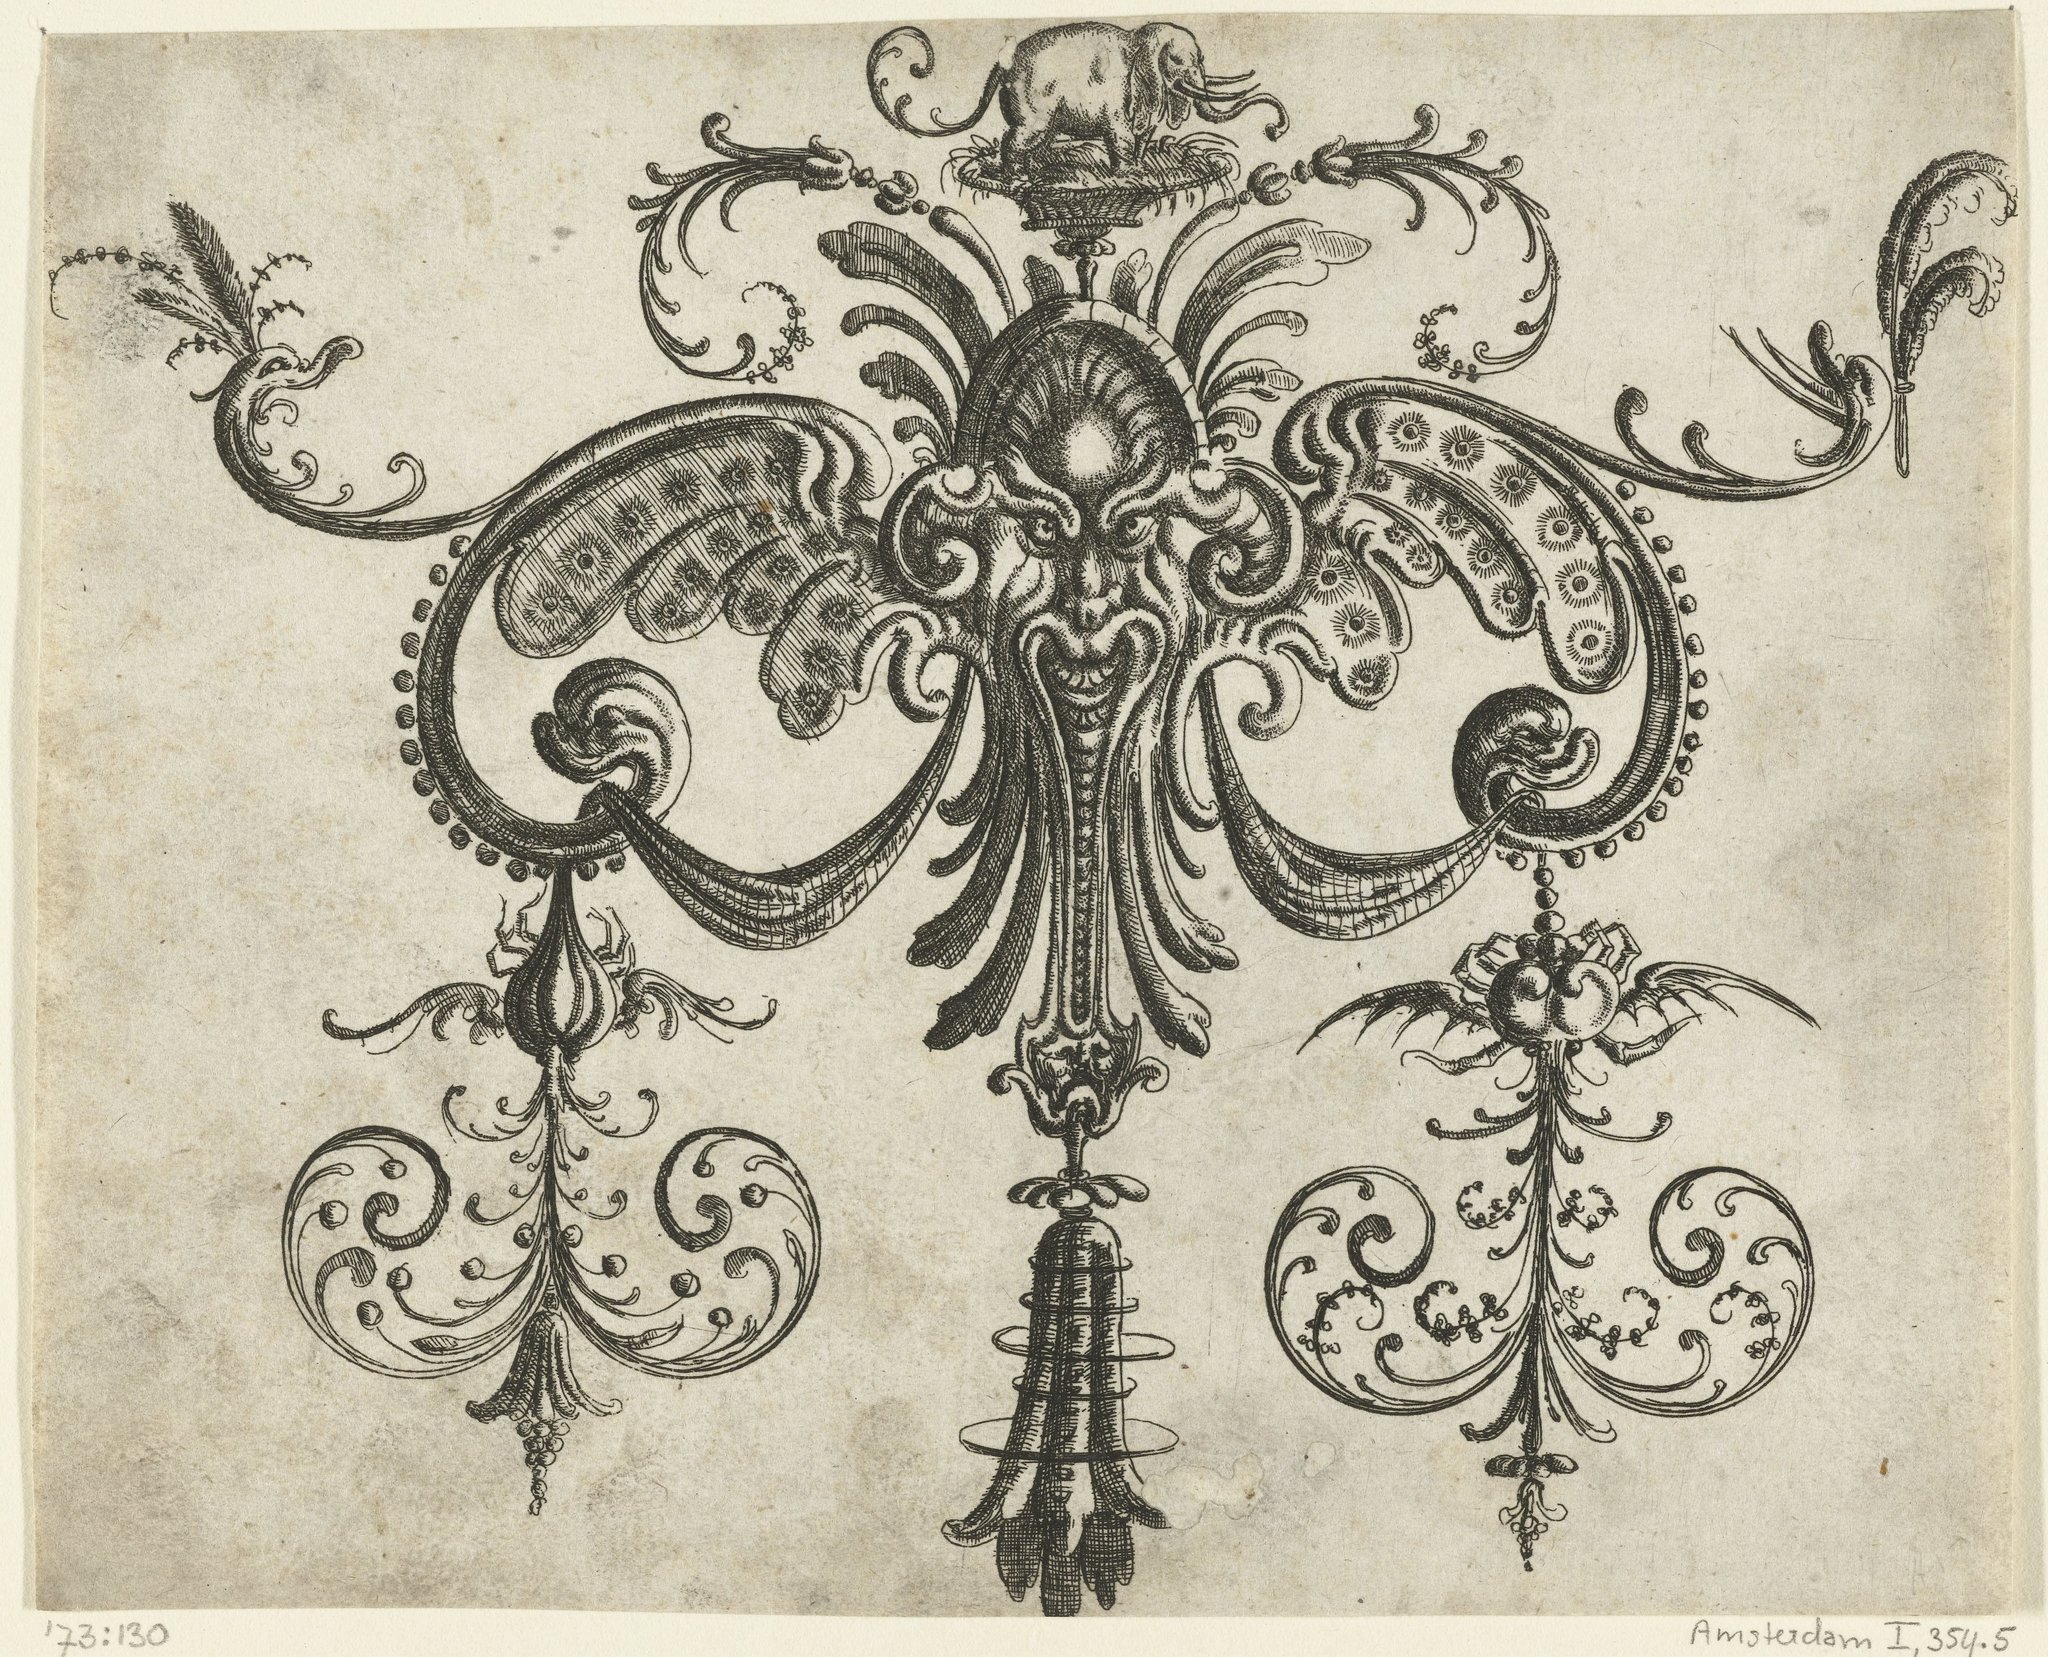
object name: print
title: Das Neuw Grottesken Buch Nürnberg 1610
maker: christoph jamnitzer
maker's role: draughtsman, goldsmith, print maker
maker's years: 1563-1618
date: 1573-1610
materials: paper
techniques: etching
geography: germany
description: Op het hoofd van de mascaron rust een plateau waarop een olifantje staat. Blad uit een serie vlakdecoraties met grotesken, cartouches, ovalen, mascarons, putti en fantastische wezens. De serie bestaat uit drie titelbladen, twee tekstbladen met de opdracht en het voorwoord en 60 bladen, verdeeld over drie boeken.